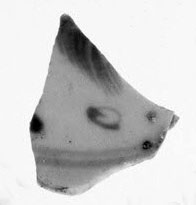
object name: shard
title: Shard (Study Collection)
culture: chinese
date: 1368-1911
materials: porcelain